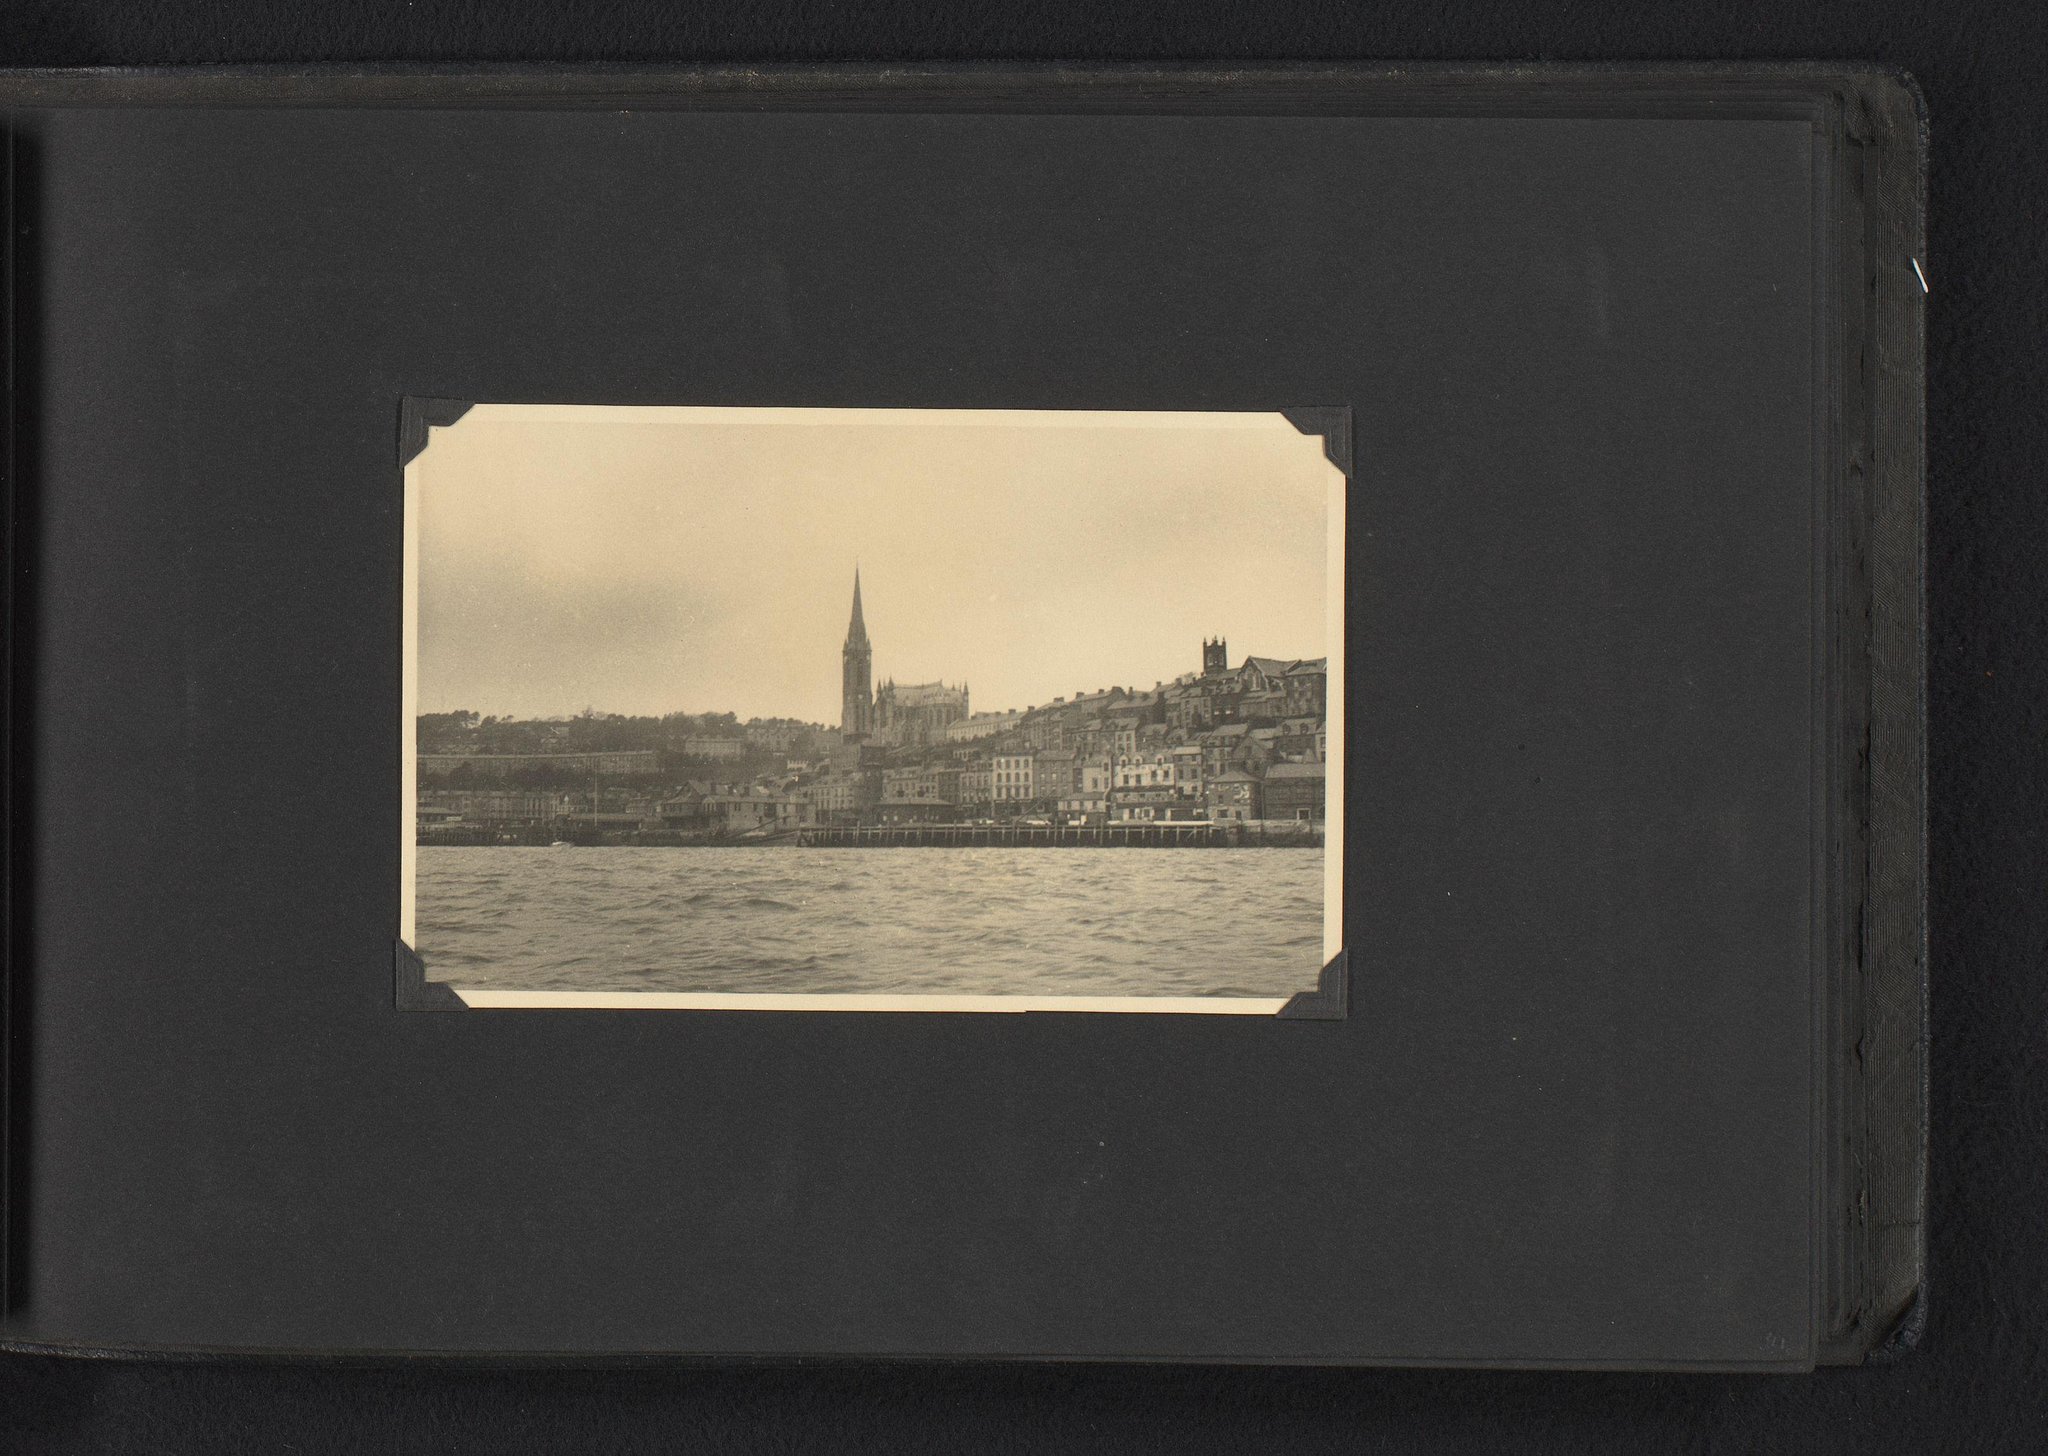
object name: album leaf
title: Gezicht op de Engelse zuidkust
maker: frank willem van den berg (1912-1998)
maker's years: 1912-1998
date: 1934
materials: paper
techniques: gelatin silver print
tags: city-view in general; 'veduta', england